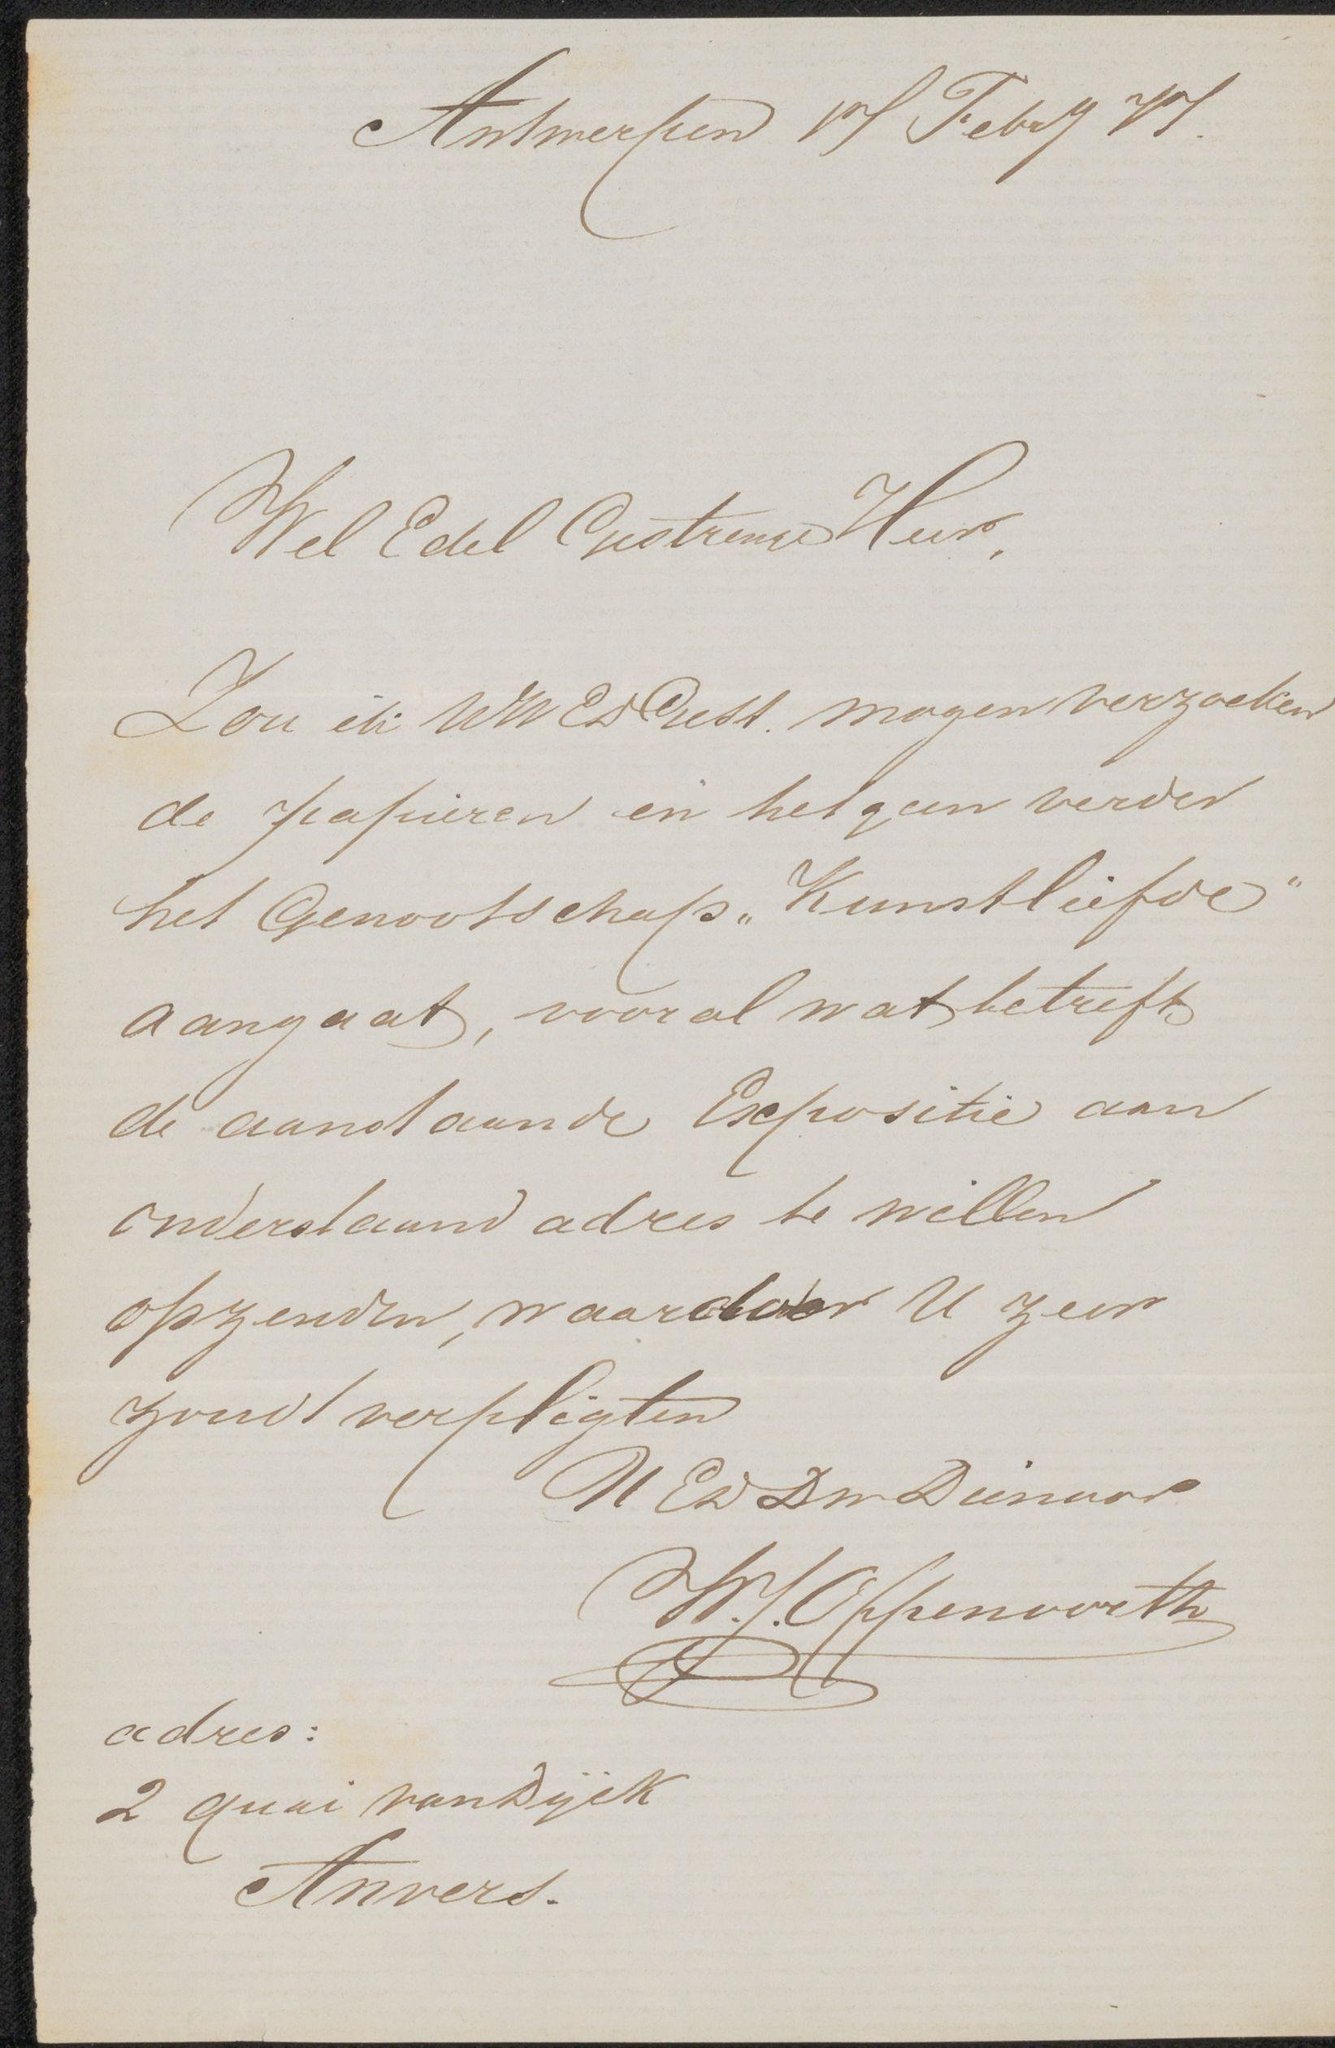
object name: letter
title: Brief aan anoniem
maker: willem oppenoorth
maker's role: draughtsman, painter, print maker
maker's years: 1847-1905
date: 1877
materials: ink, paper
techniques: pen, writing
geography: antwerp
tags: exhibition ~ art